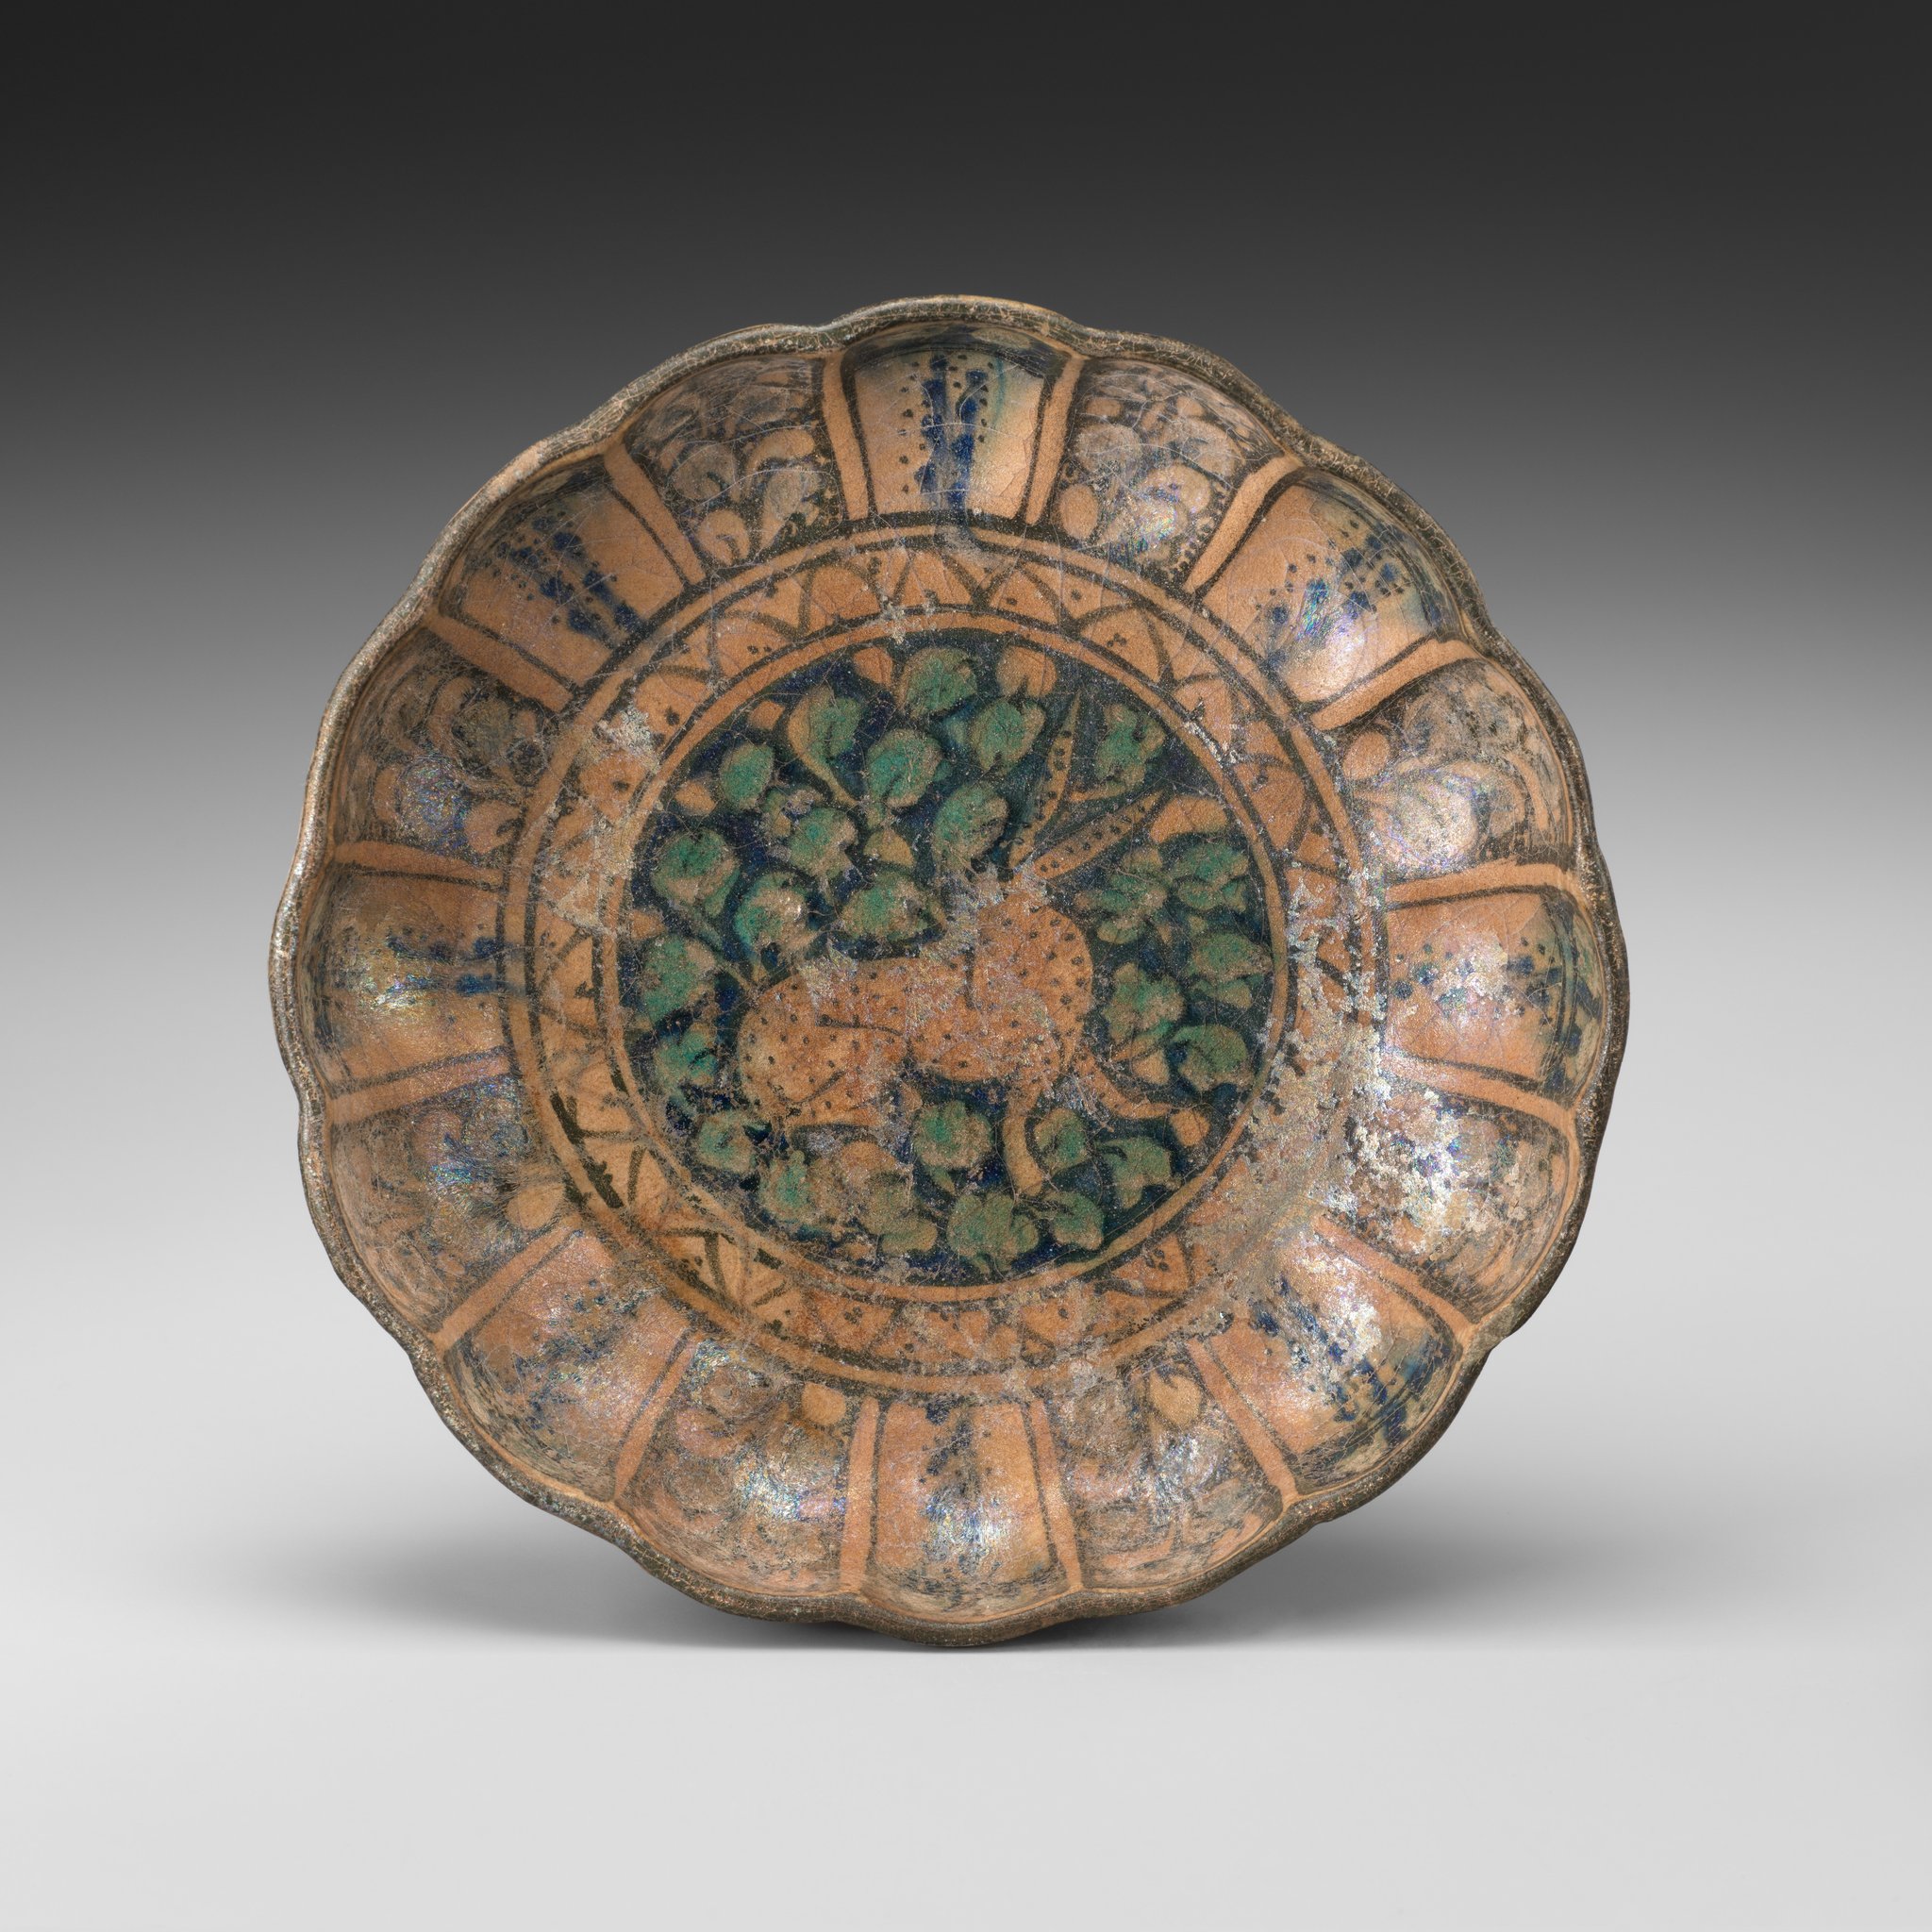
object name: dish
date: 1301-1400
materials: earthenware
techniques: painting, underglaze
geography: iran